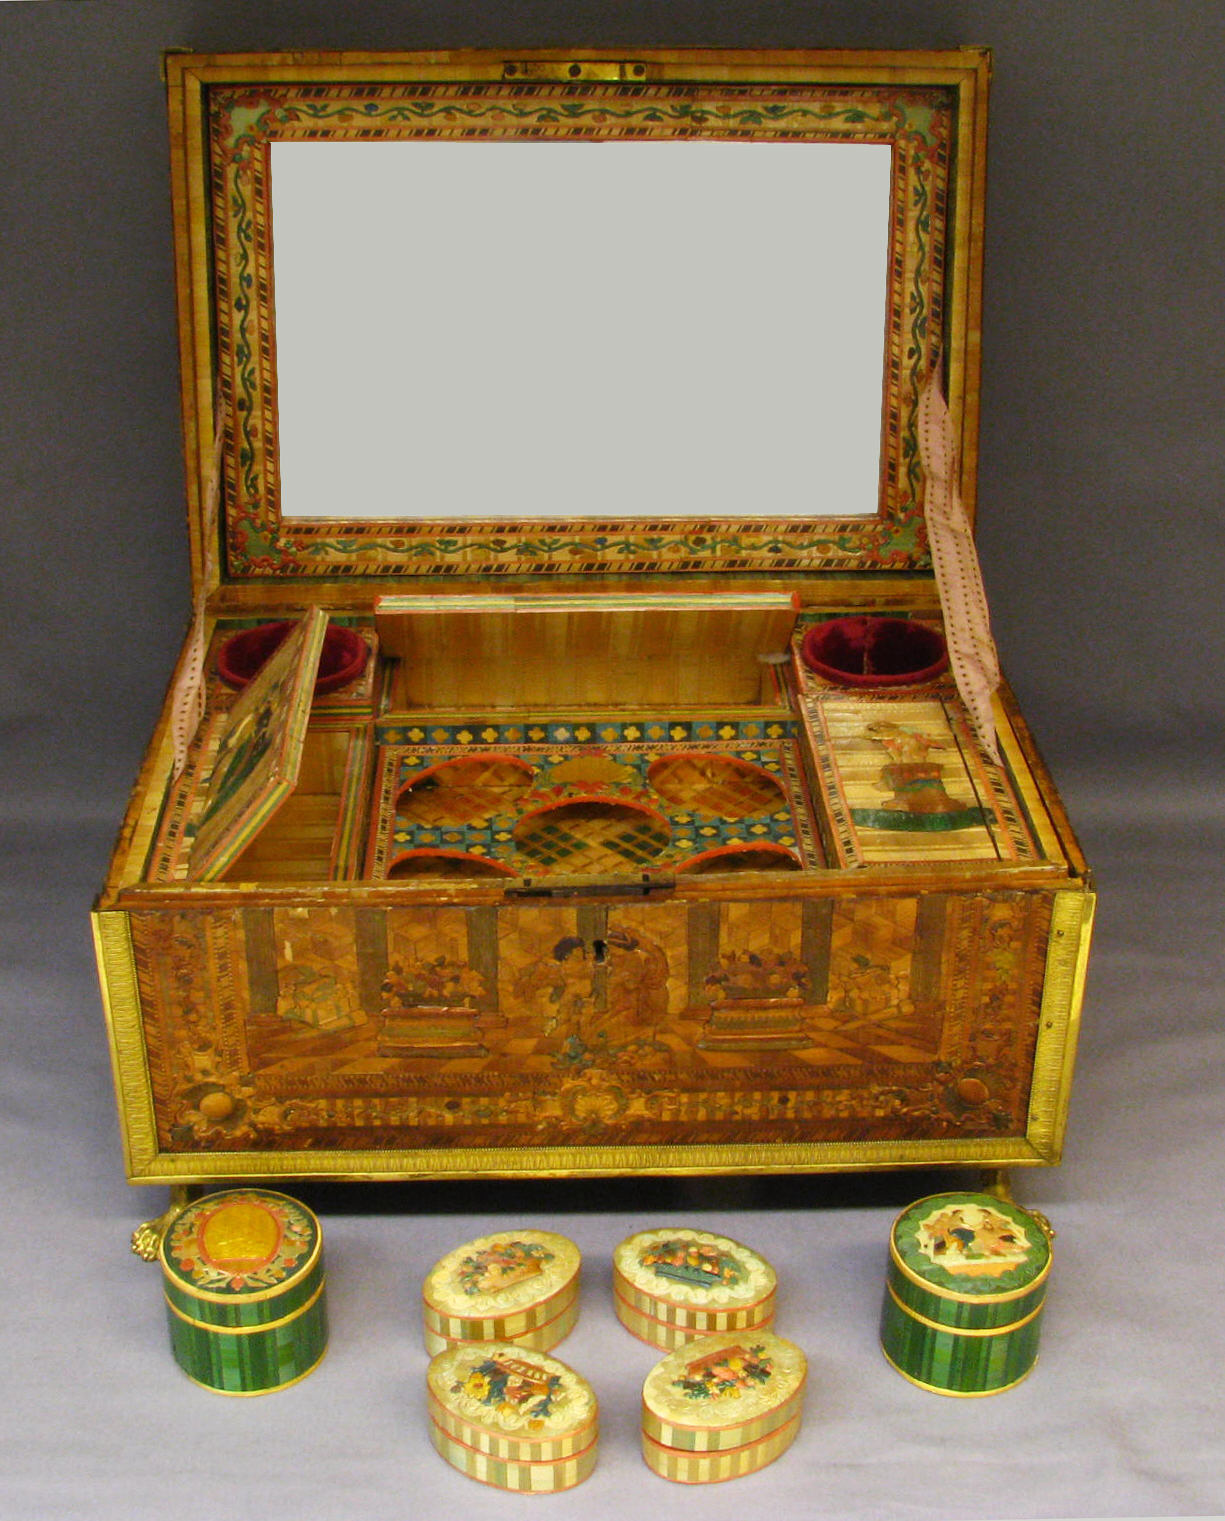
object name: toilet box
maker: jean-pierre droz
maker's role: artist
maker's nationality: french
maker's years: 1746-1823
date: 1804-1814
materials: gilt bronze, fiber, wood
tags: human figures